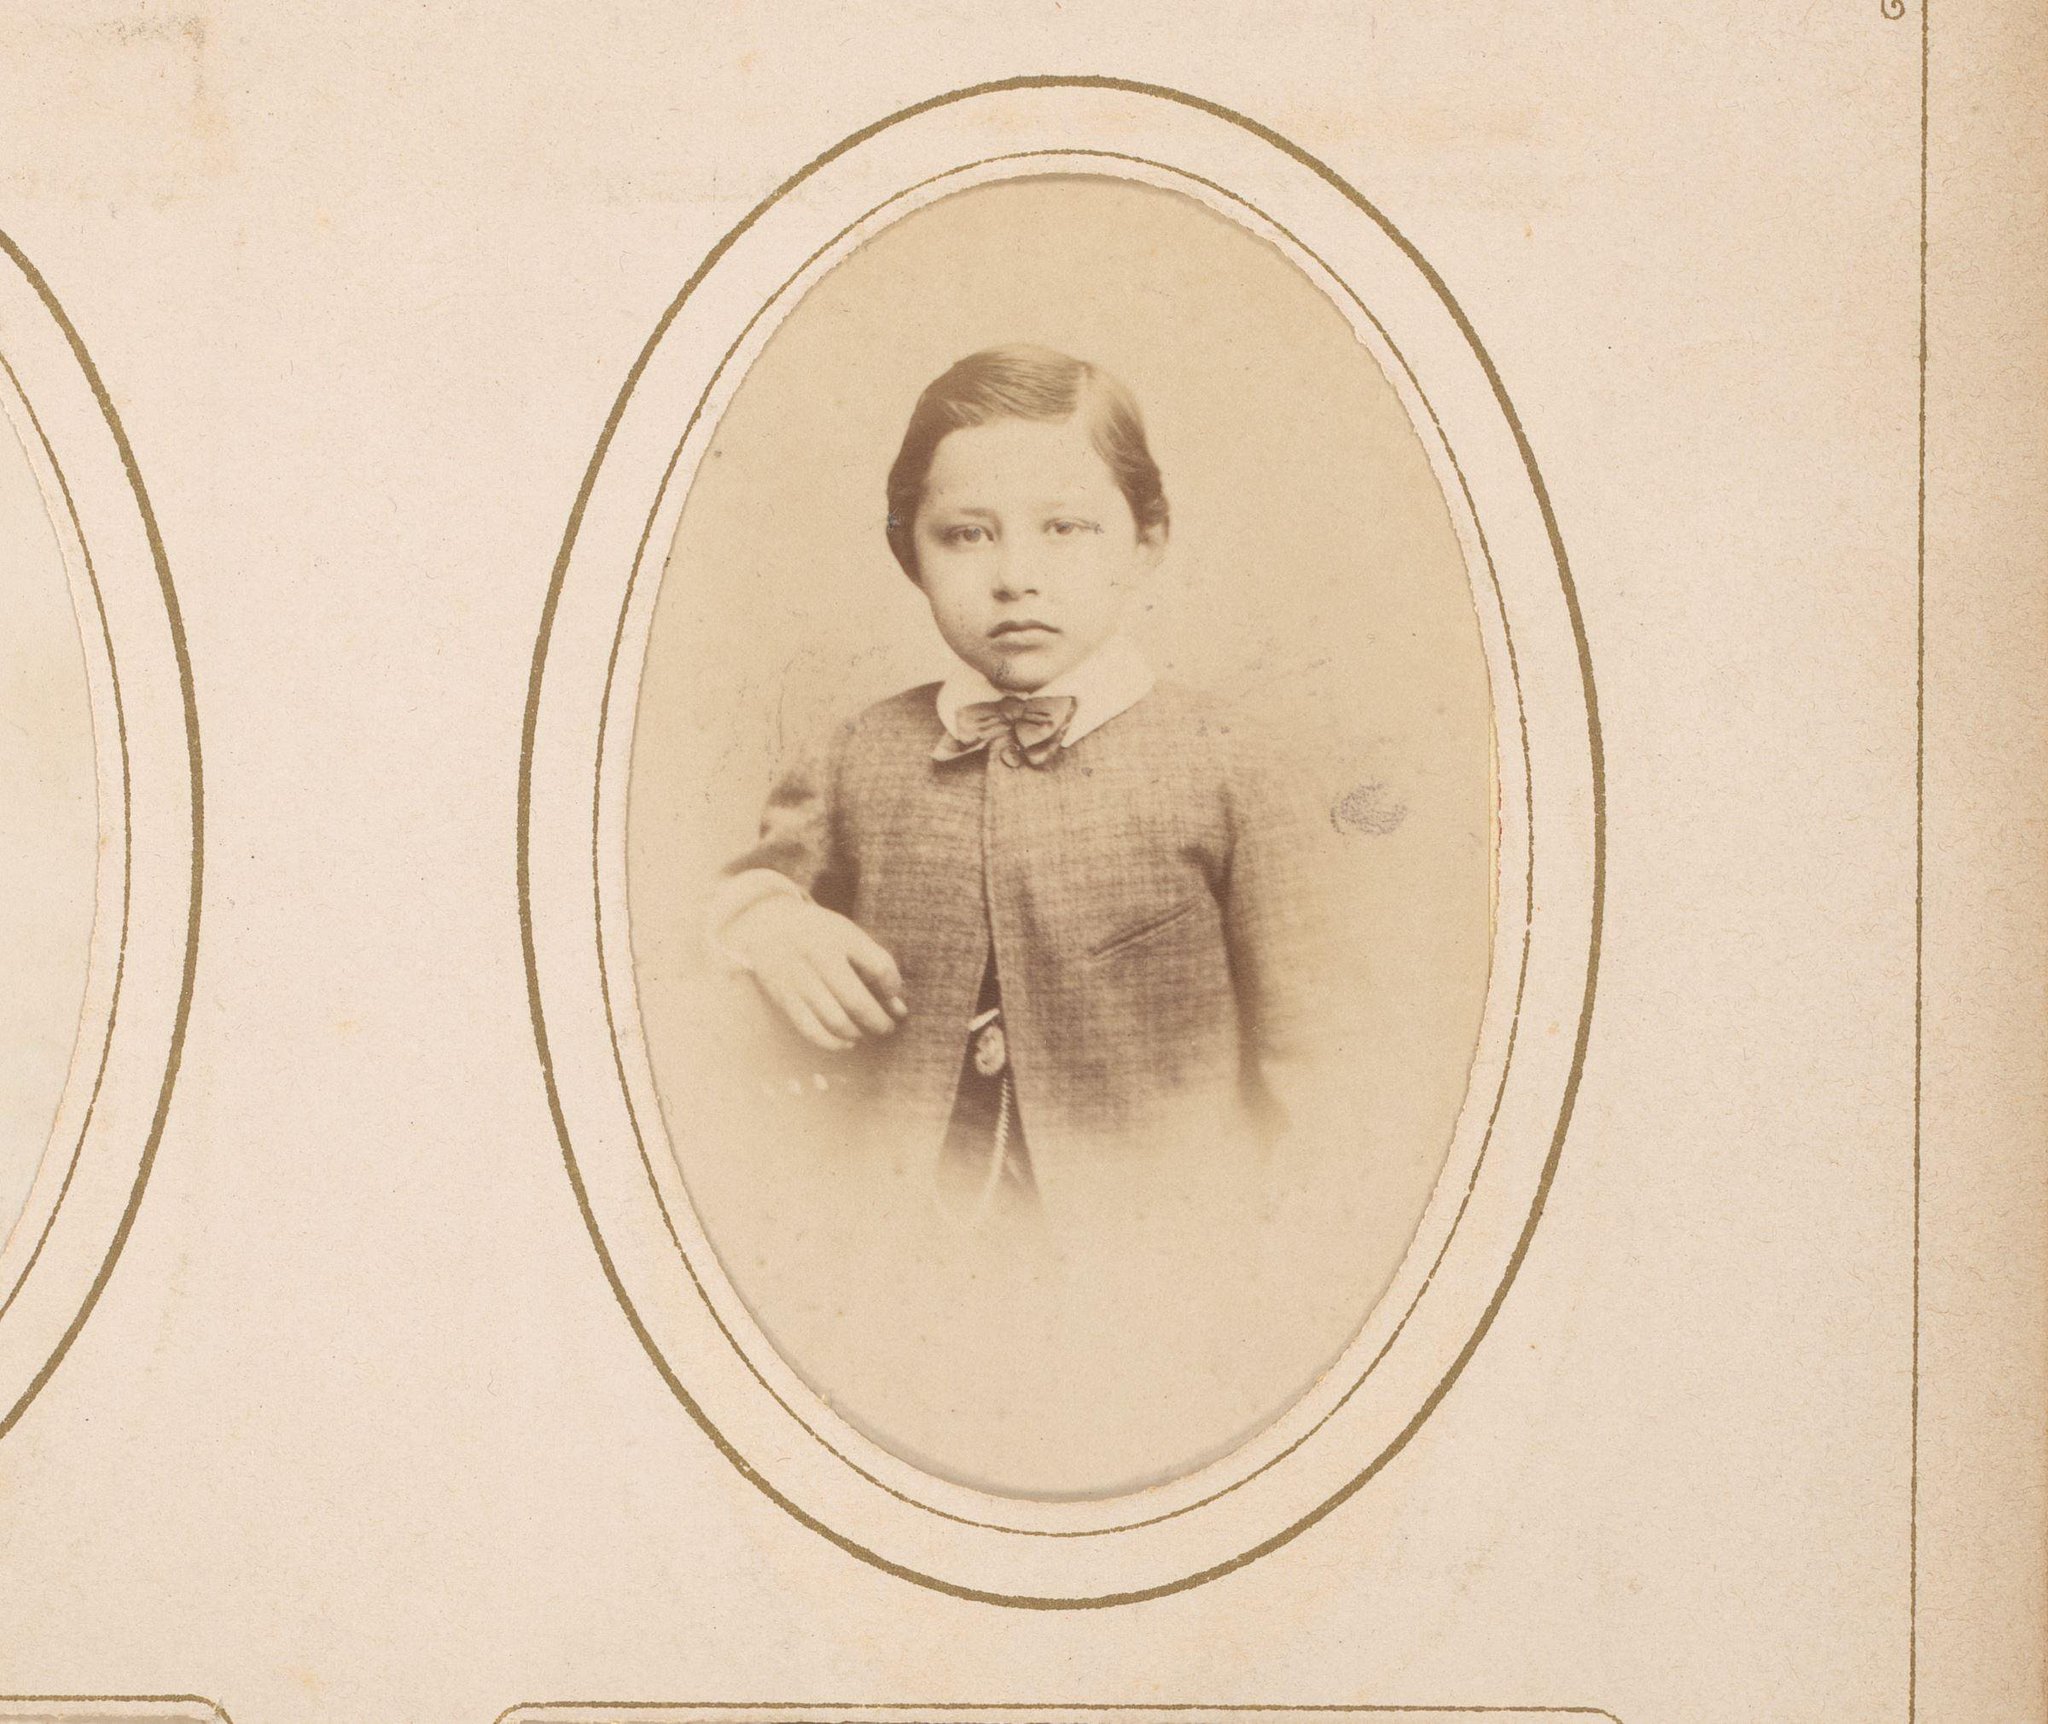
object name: carte de visite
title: Portret van een jongen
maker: willem frederik vinkenbos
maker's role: fotograaf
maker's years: 1831-1896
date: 1870-1877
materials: cardboard, photographic support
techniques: albumen print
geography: the hague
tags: historical persons, toddler (male)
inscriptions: inscription: ‘WFV/ PHOTOGR. ATELIER/ W. F. VINKENBOS/ Kerkstraat No 21/ 's HAGE.’